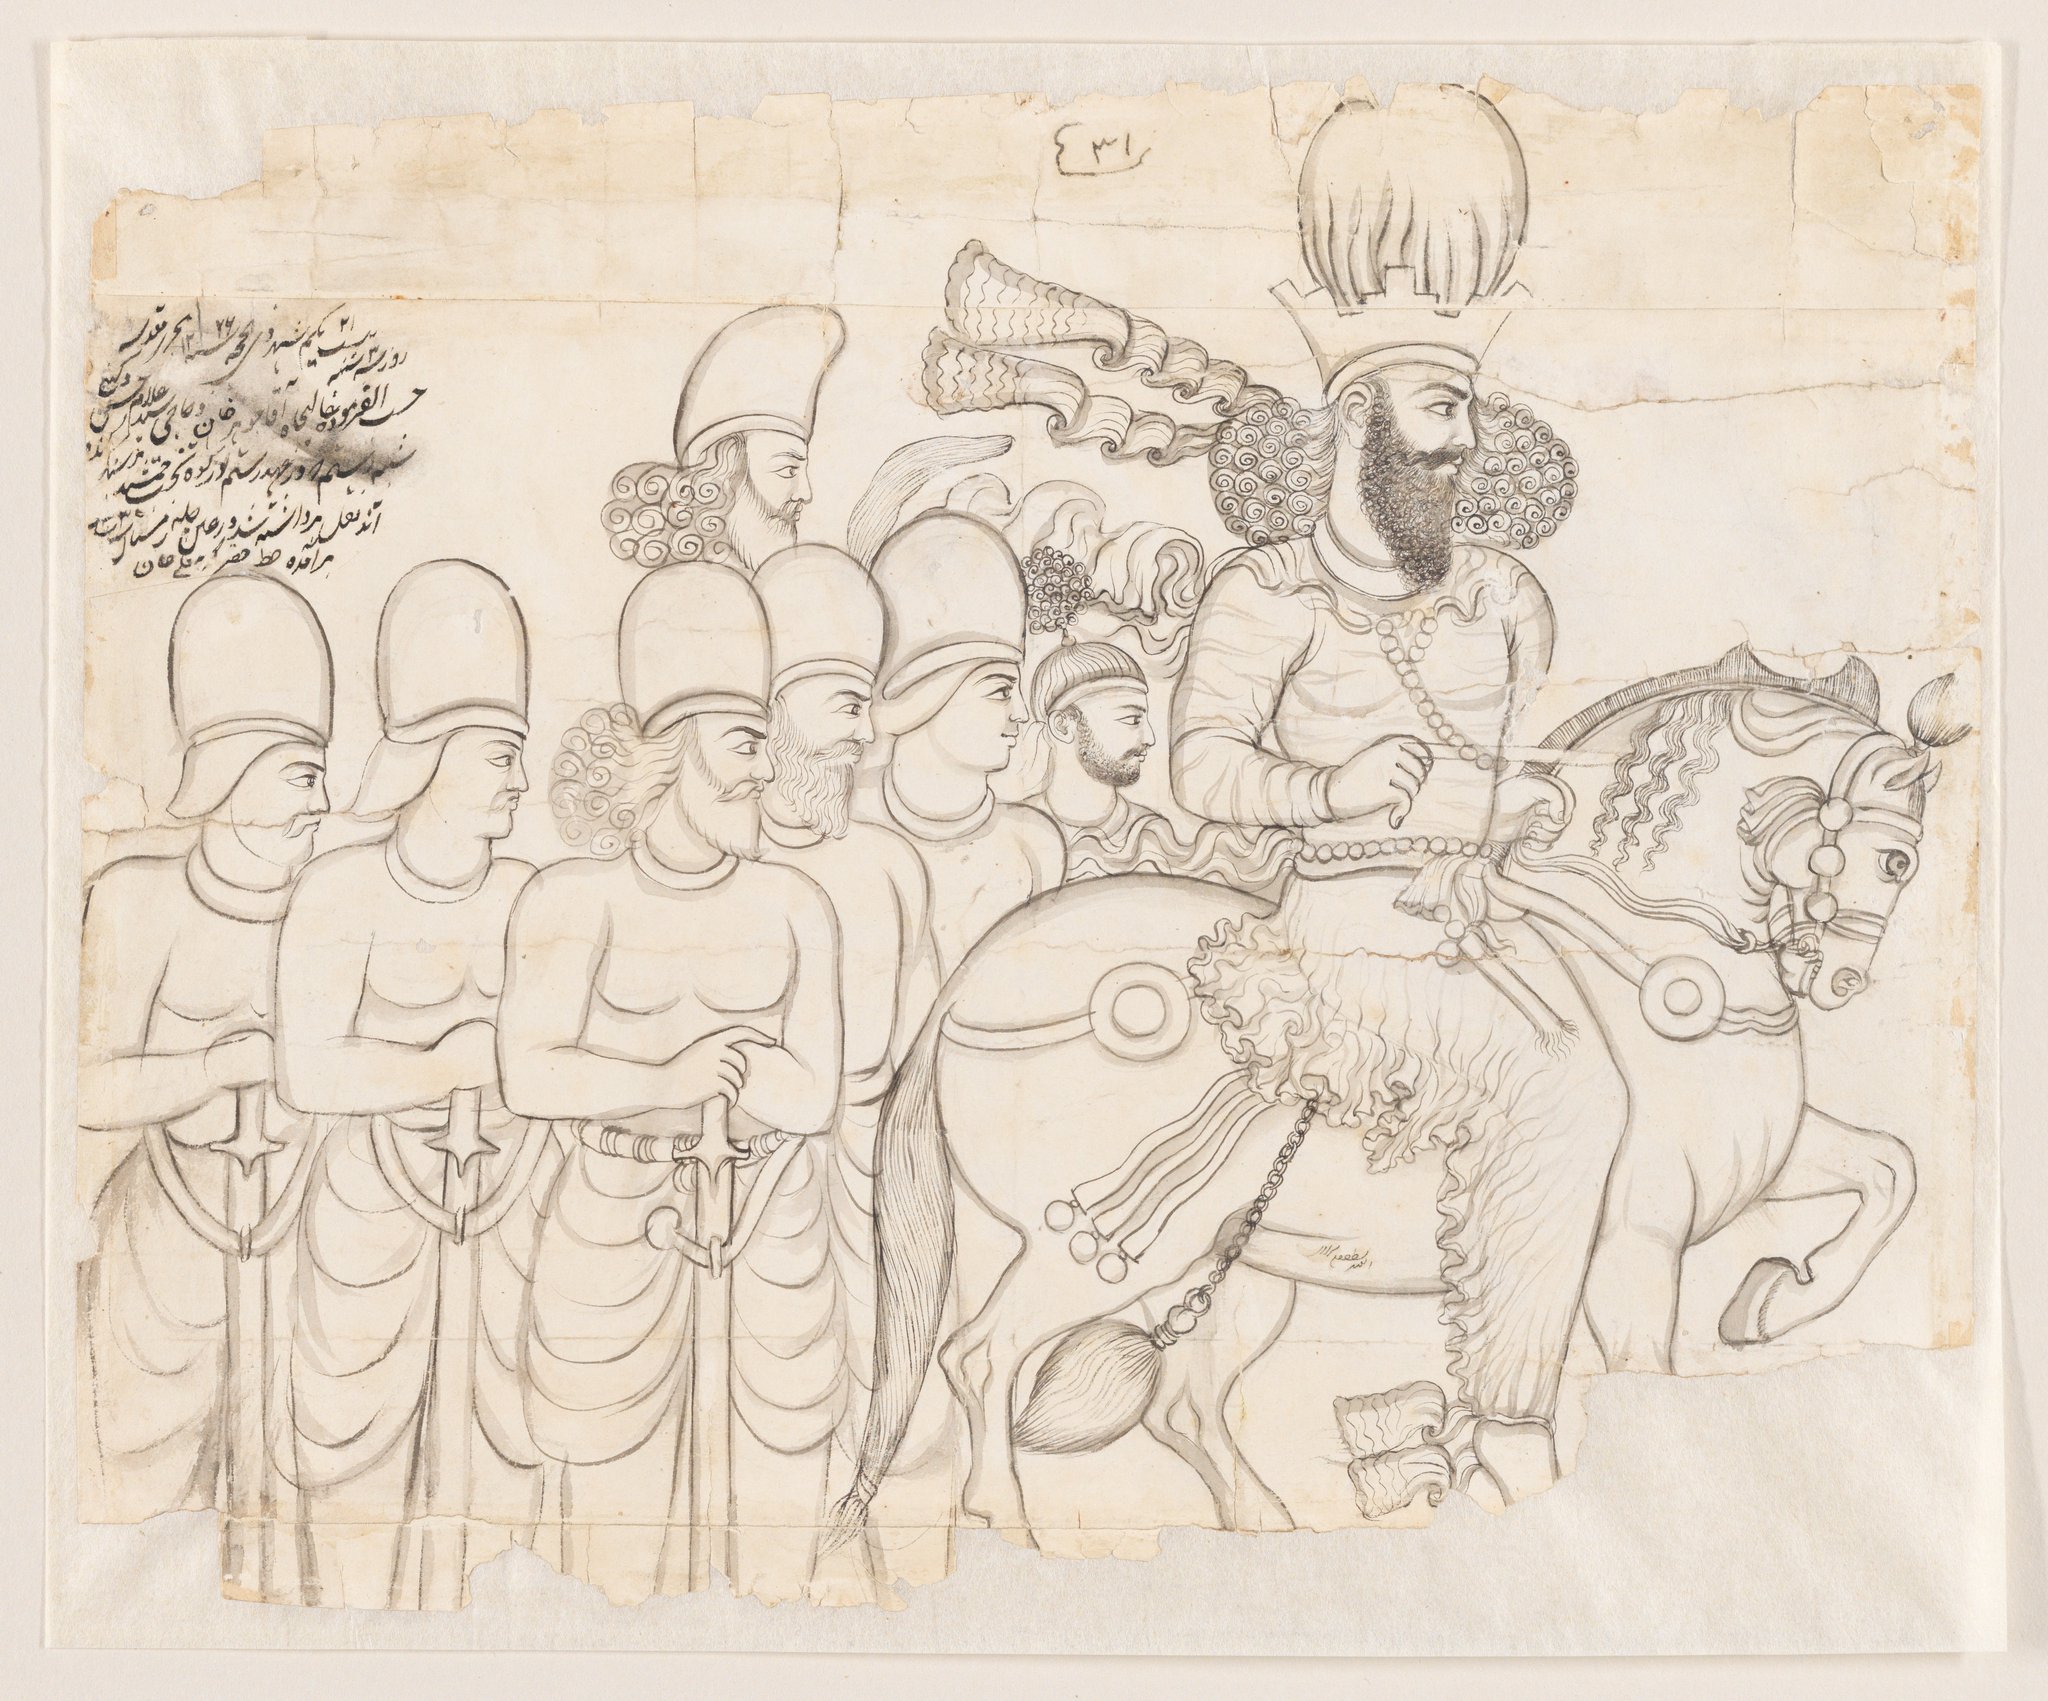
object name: drawing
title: Drawing of Sasanian rock relief: Shapur I (r. A.D. 241-272) and members of his court at Naqsh-i Radjab, southern Iran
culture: qajar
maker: lutf-'ali shirazi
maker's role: artist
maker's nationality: iranian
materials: ink, paper, pencil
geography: iran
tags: men,horses